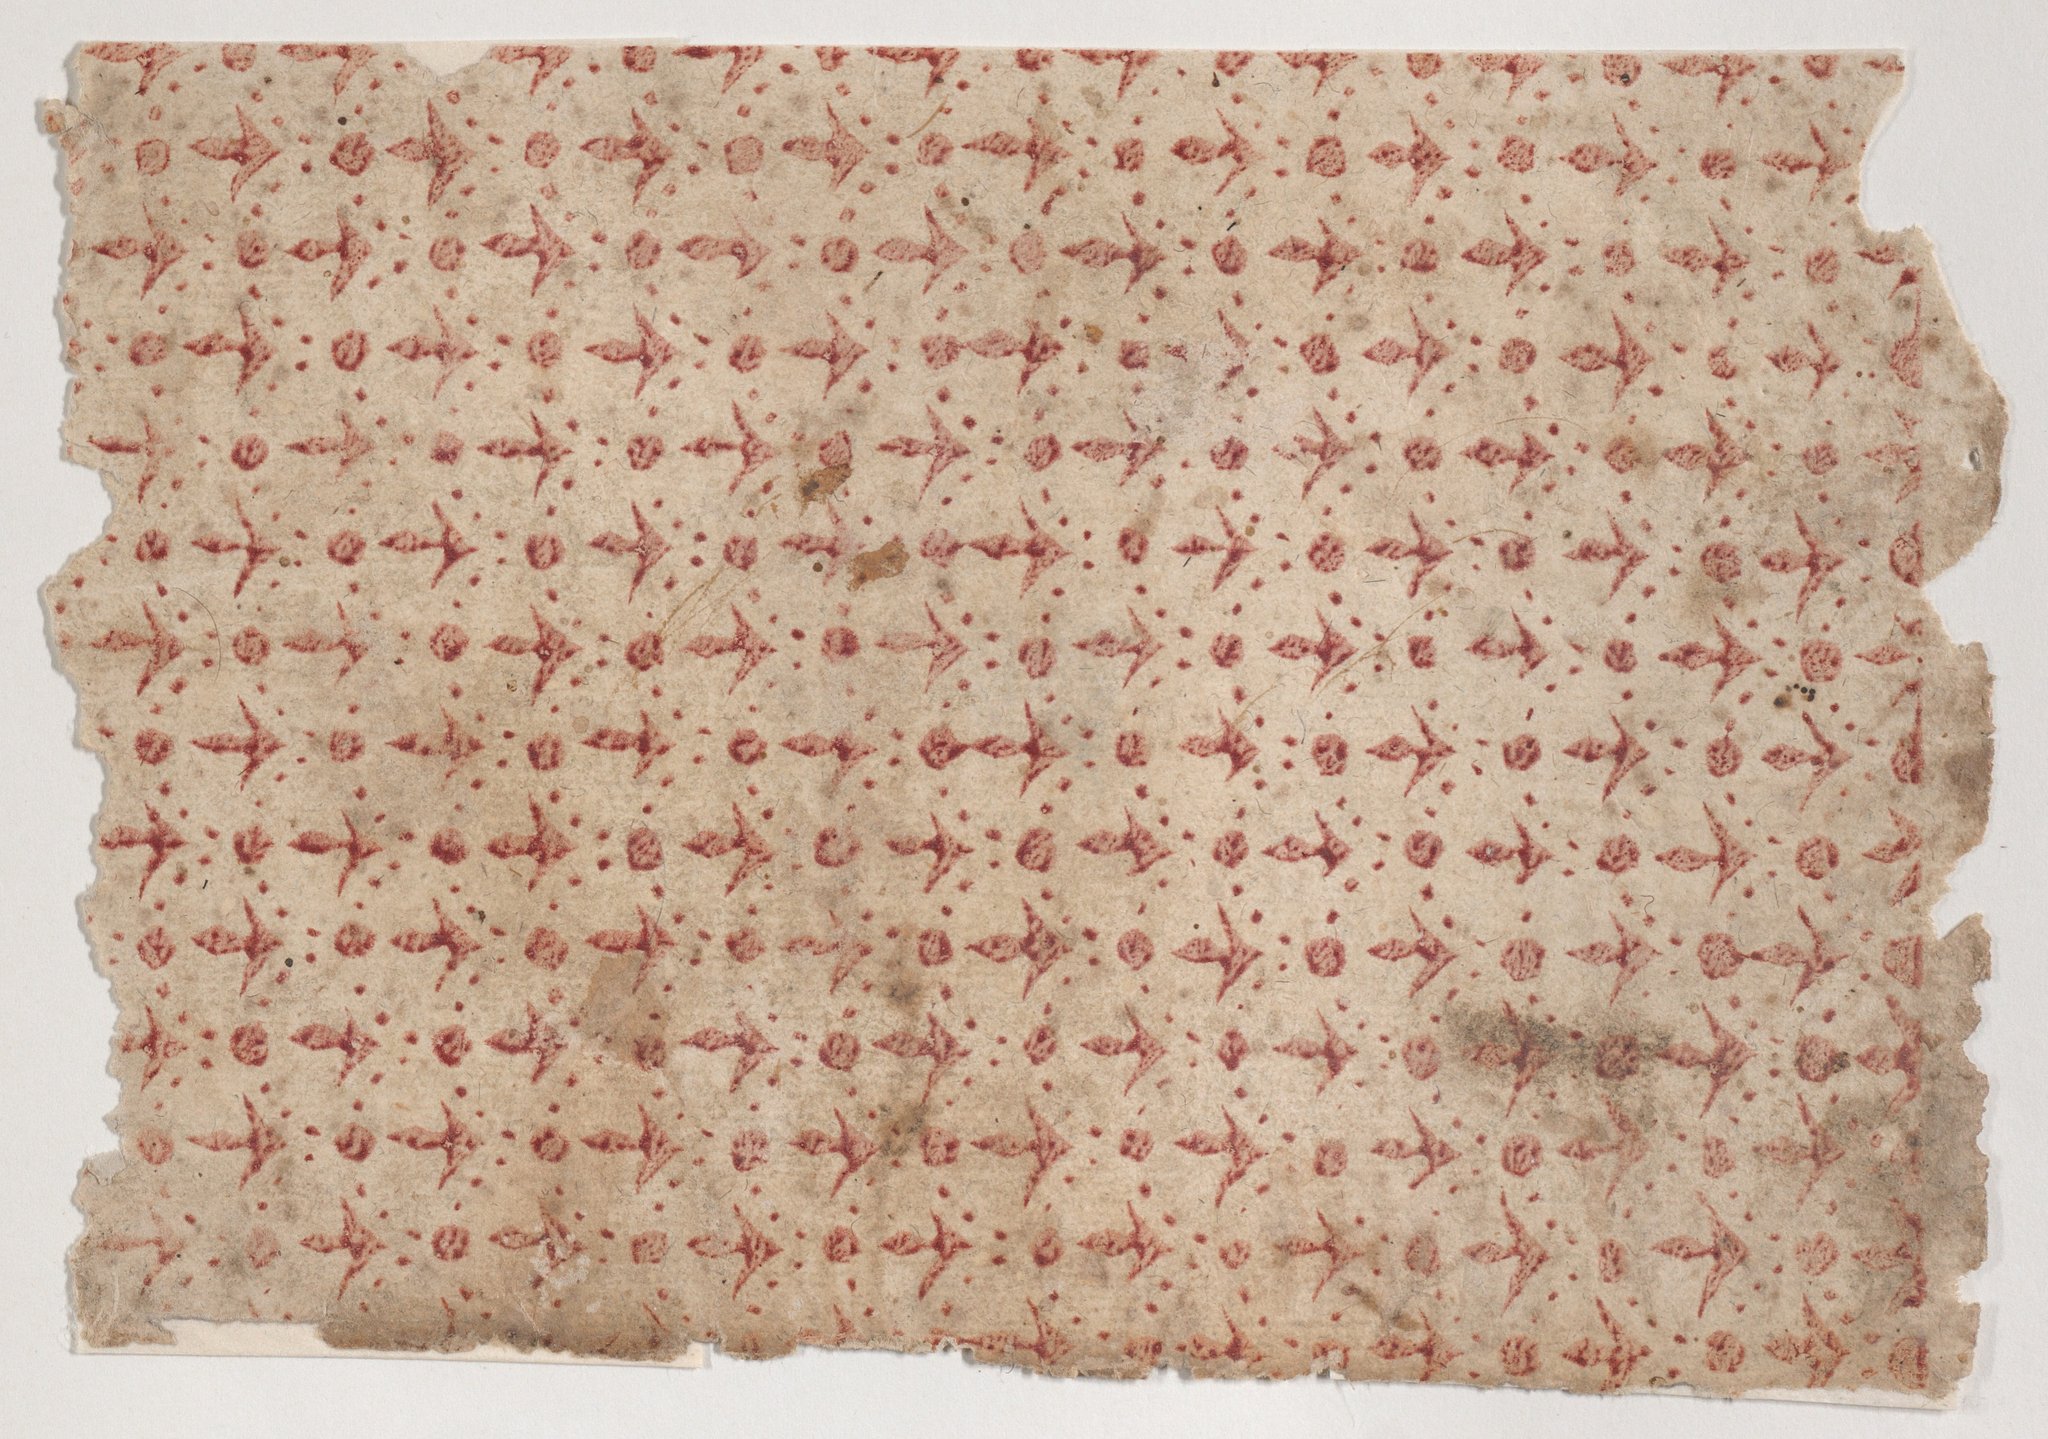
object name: print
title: Sheet with overall pattern of dots and arrow shapes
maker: Anonymous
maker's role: artist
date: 1801-1900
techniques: relief print